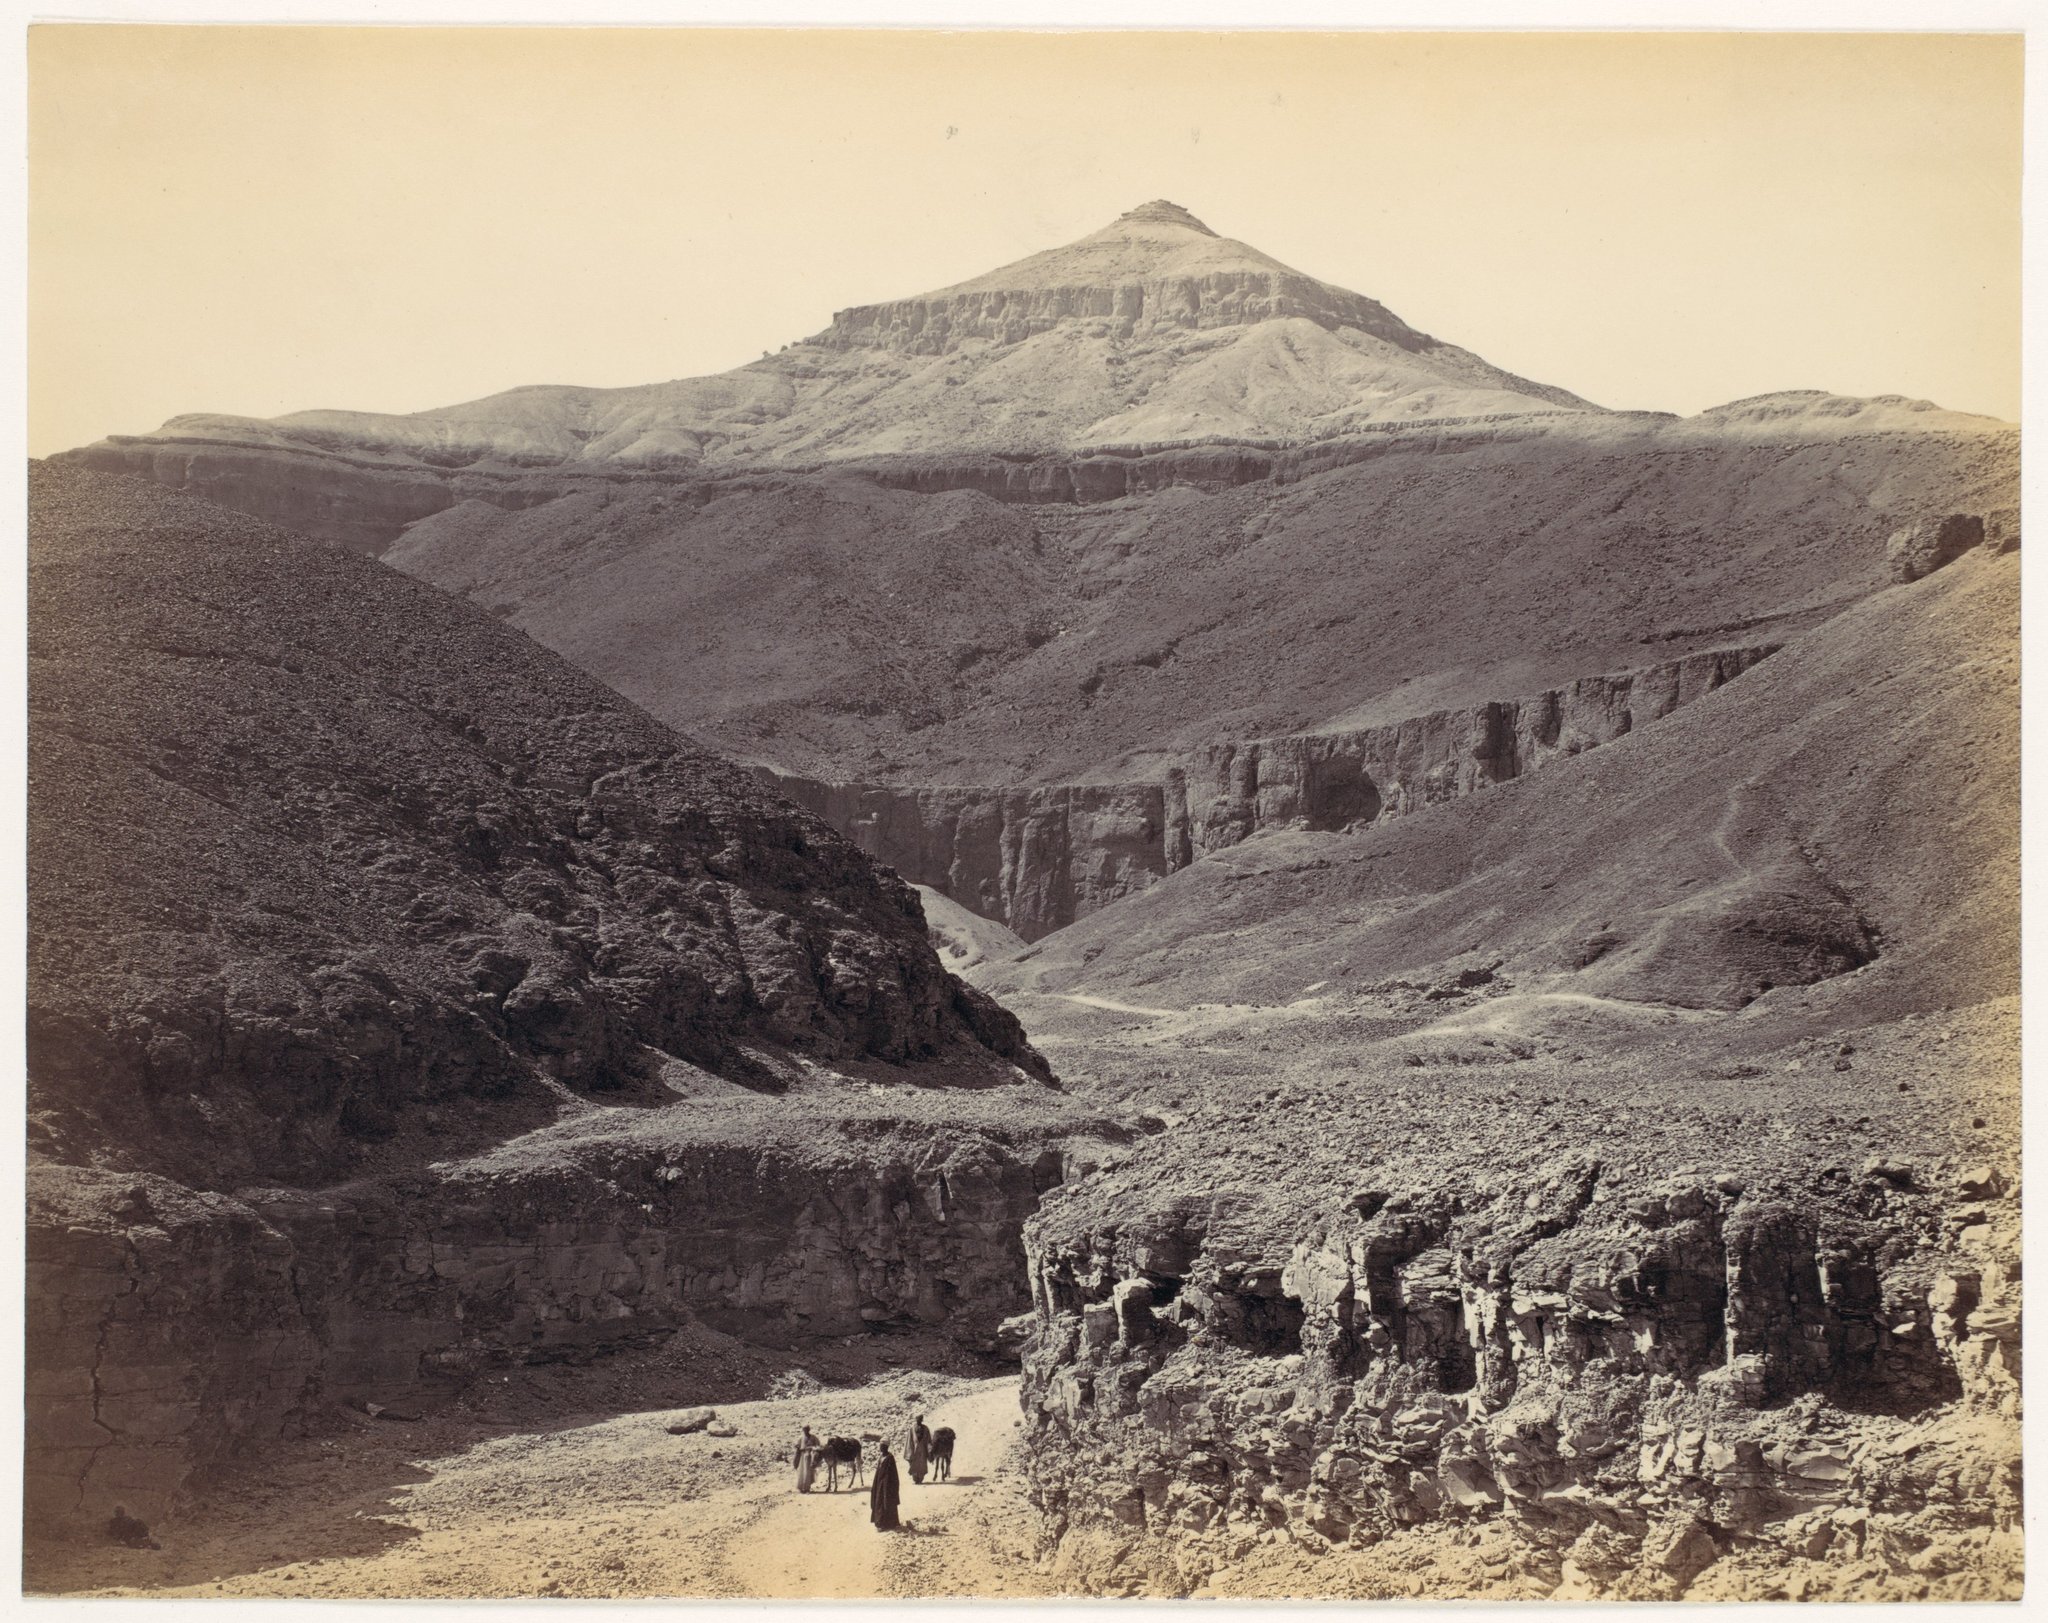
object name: photograph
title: [Valley of the Kings, Thebes]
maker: francis frith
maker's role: publisher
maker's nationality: english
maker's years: 1822-1898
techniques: albumen silver print, glass negative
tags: mountains,landscapes